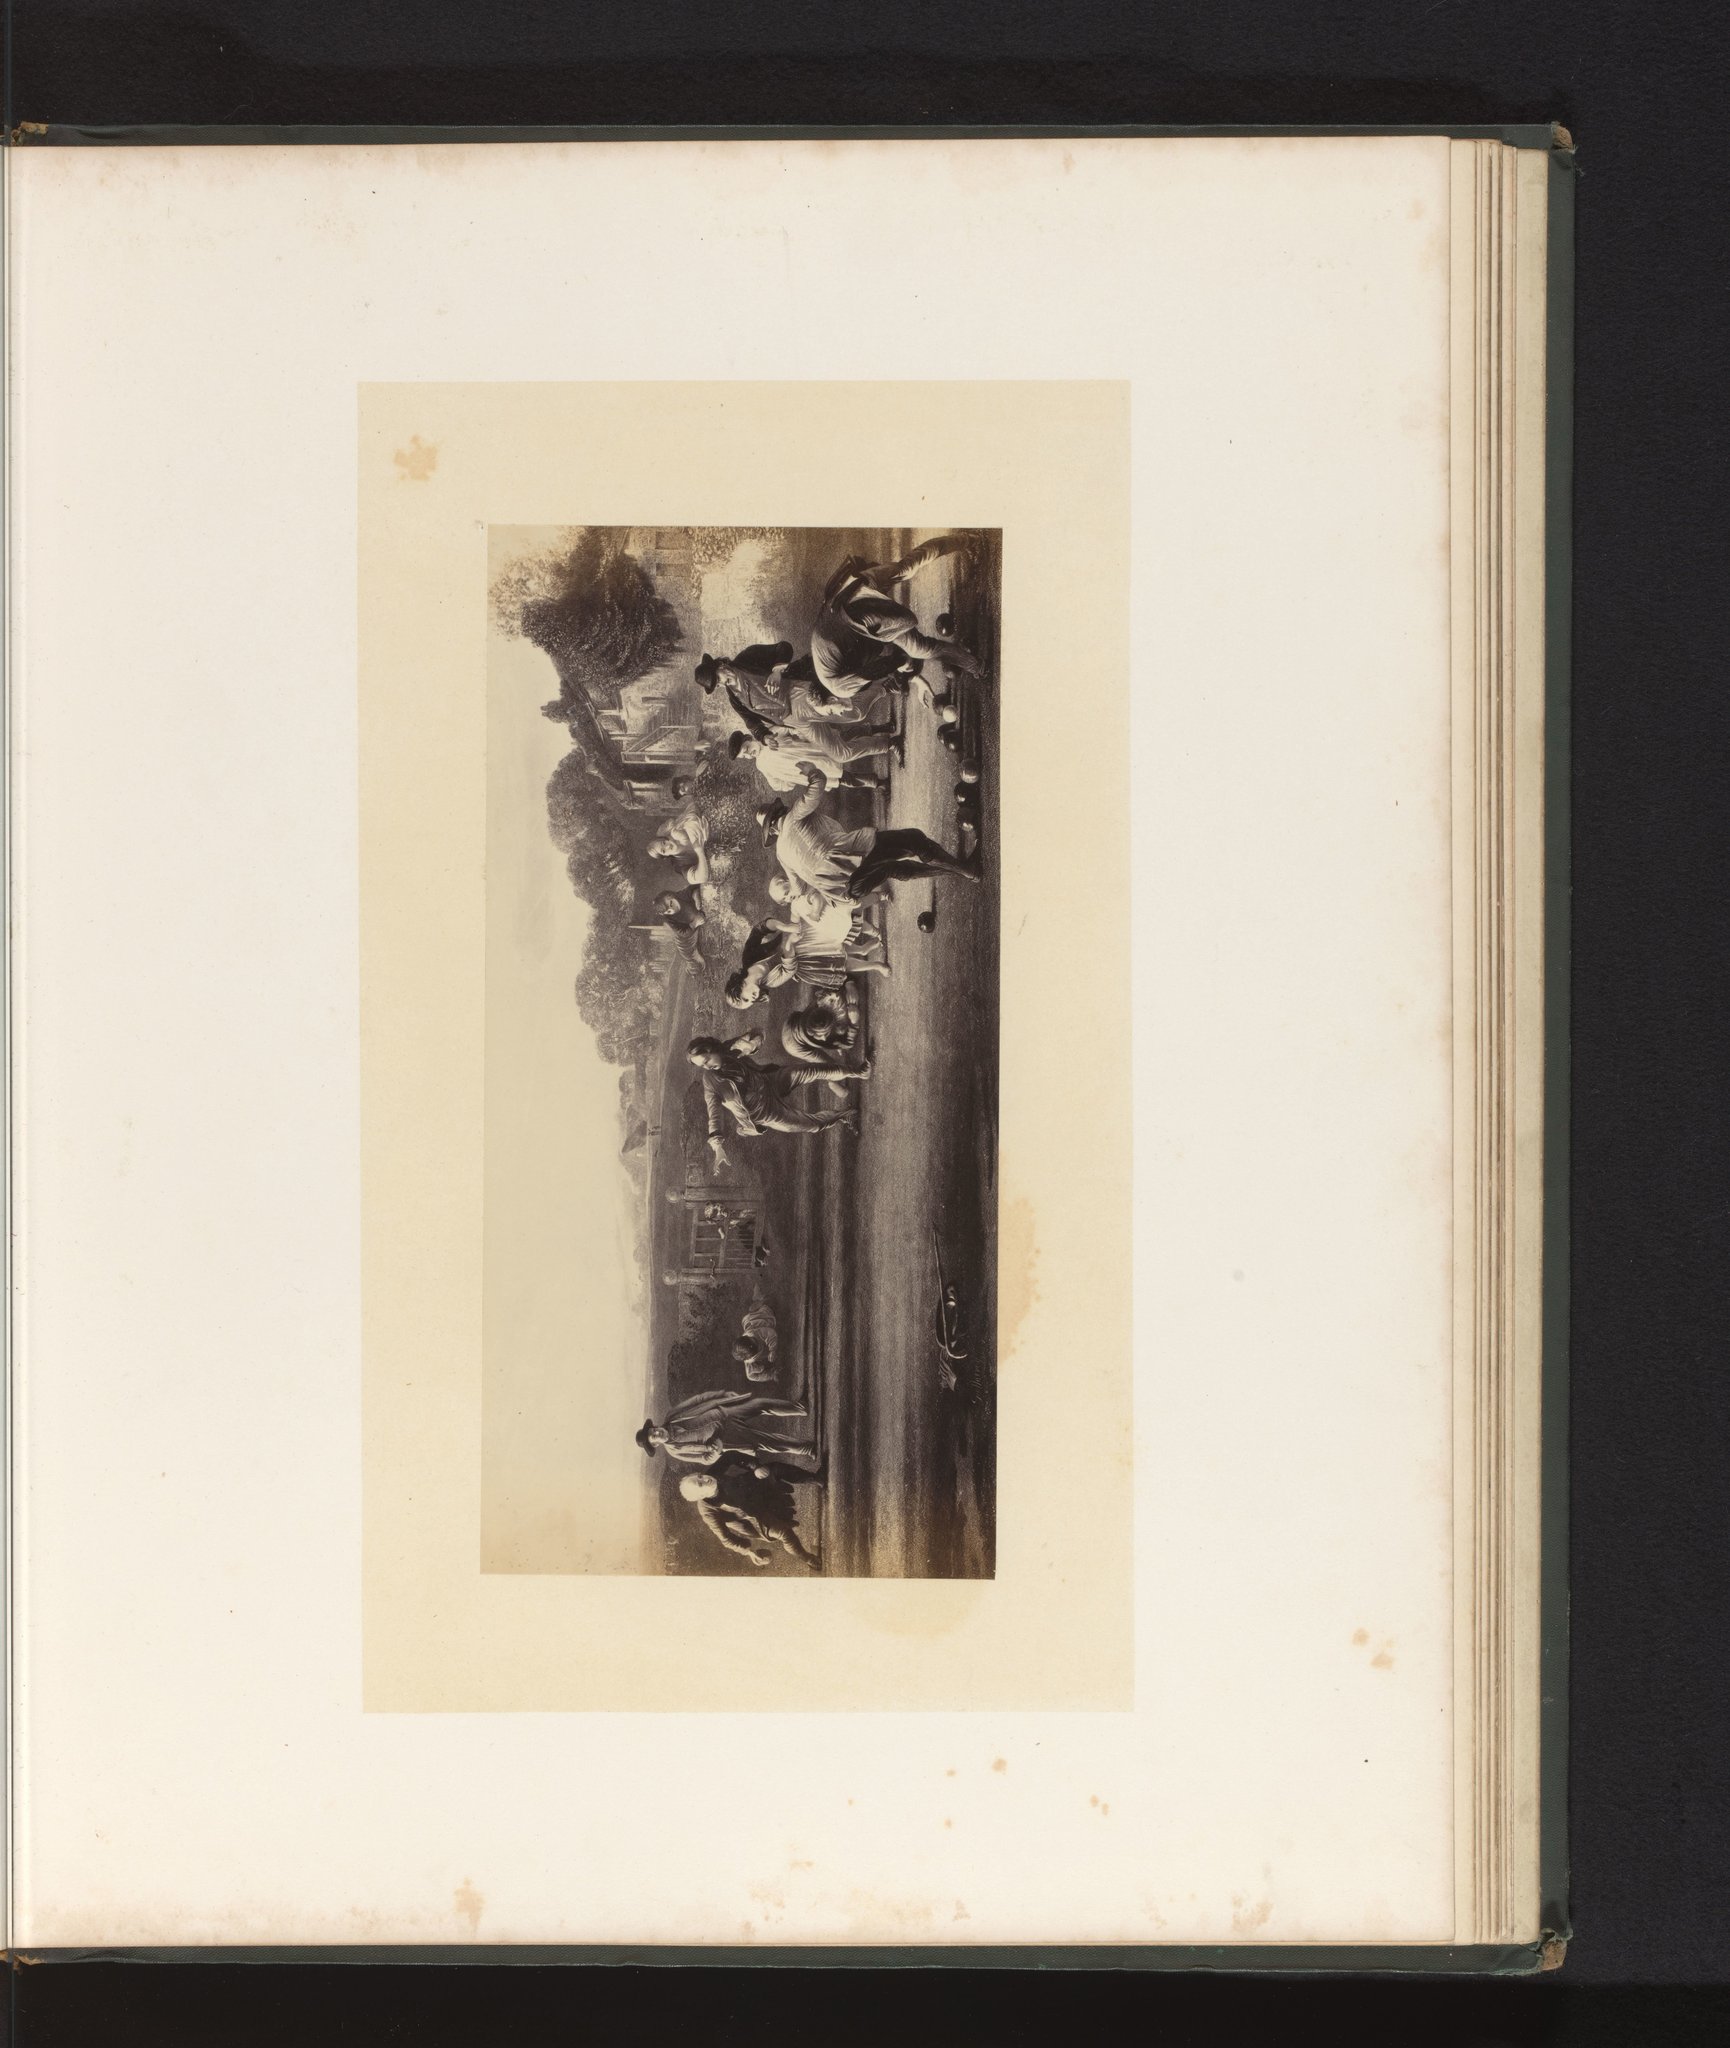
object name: page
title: Fotoreproductie van een gravure van Village Bowlers, naar het schilderij door Sir George Harvey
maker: thomas annan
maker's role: fotograaf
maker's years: 1829-1887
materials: photographic support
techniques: albumen print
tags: bowling